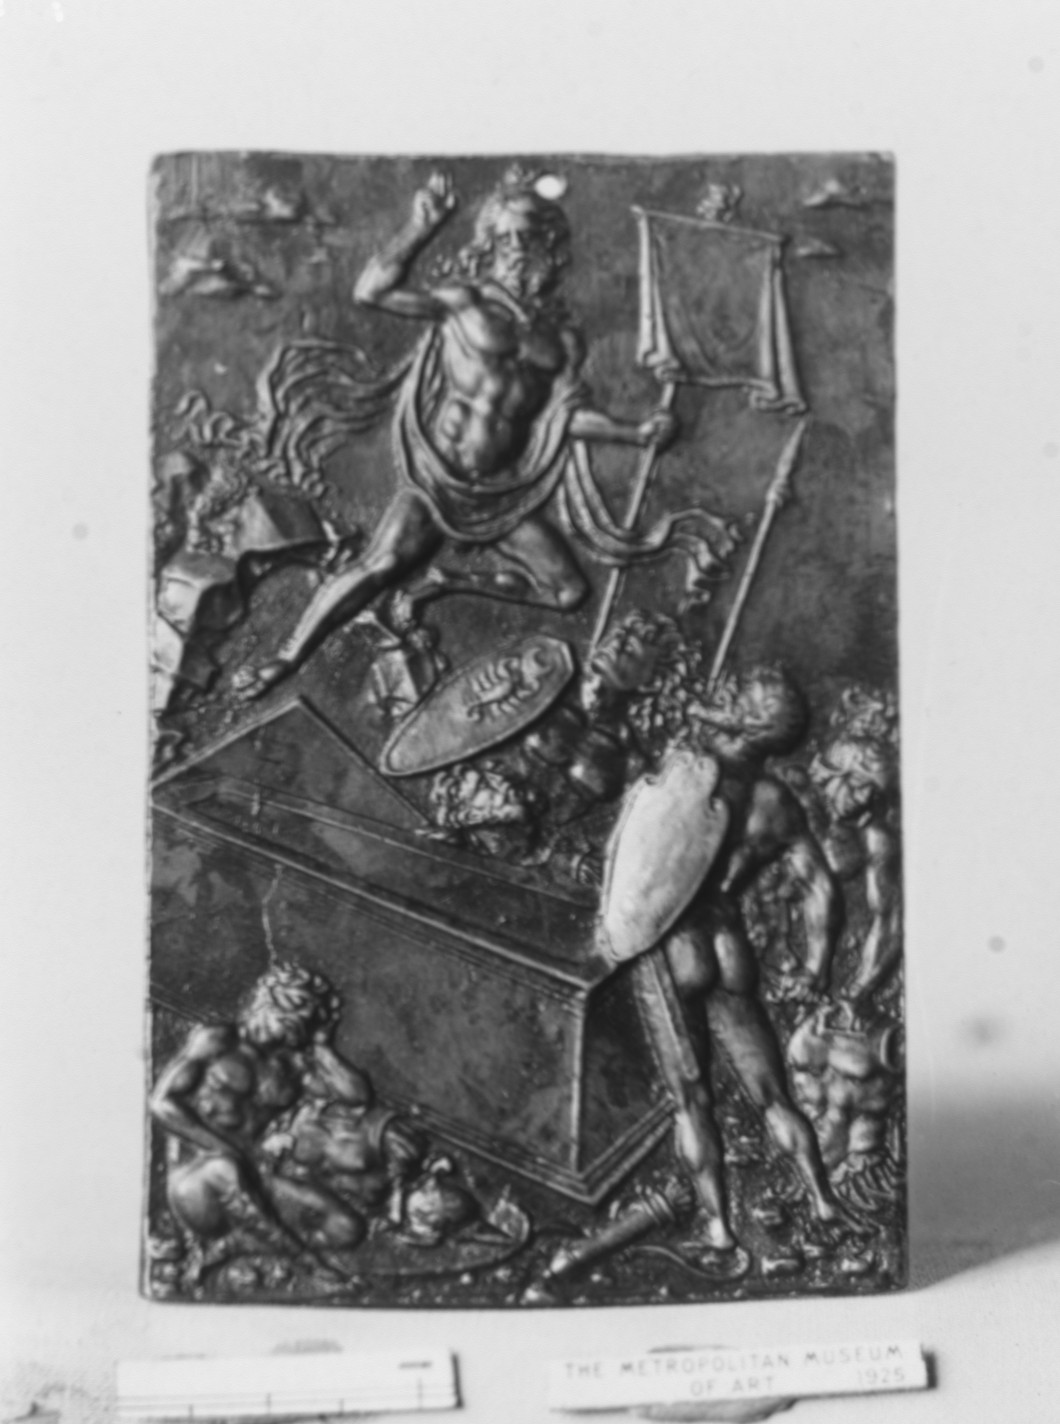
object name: plaquette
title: Resurrection of Christ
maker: moderno (galeazzo mondella)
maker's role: artist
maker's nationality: italian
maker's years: 1467-1528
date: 1467-1533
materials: bronze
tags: christ